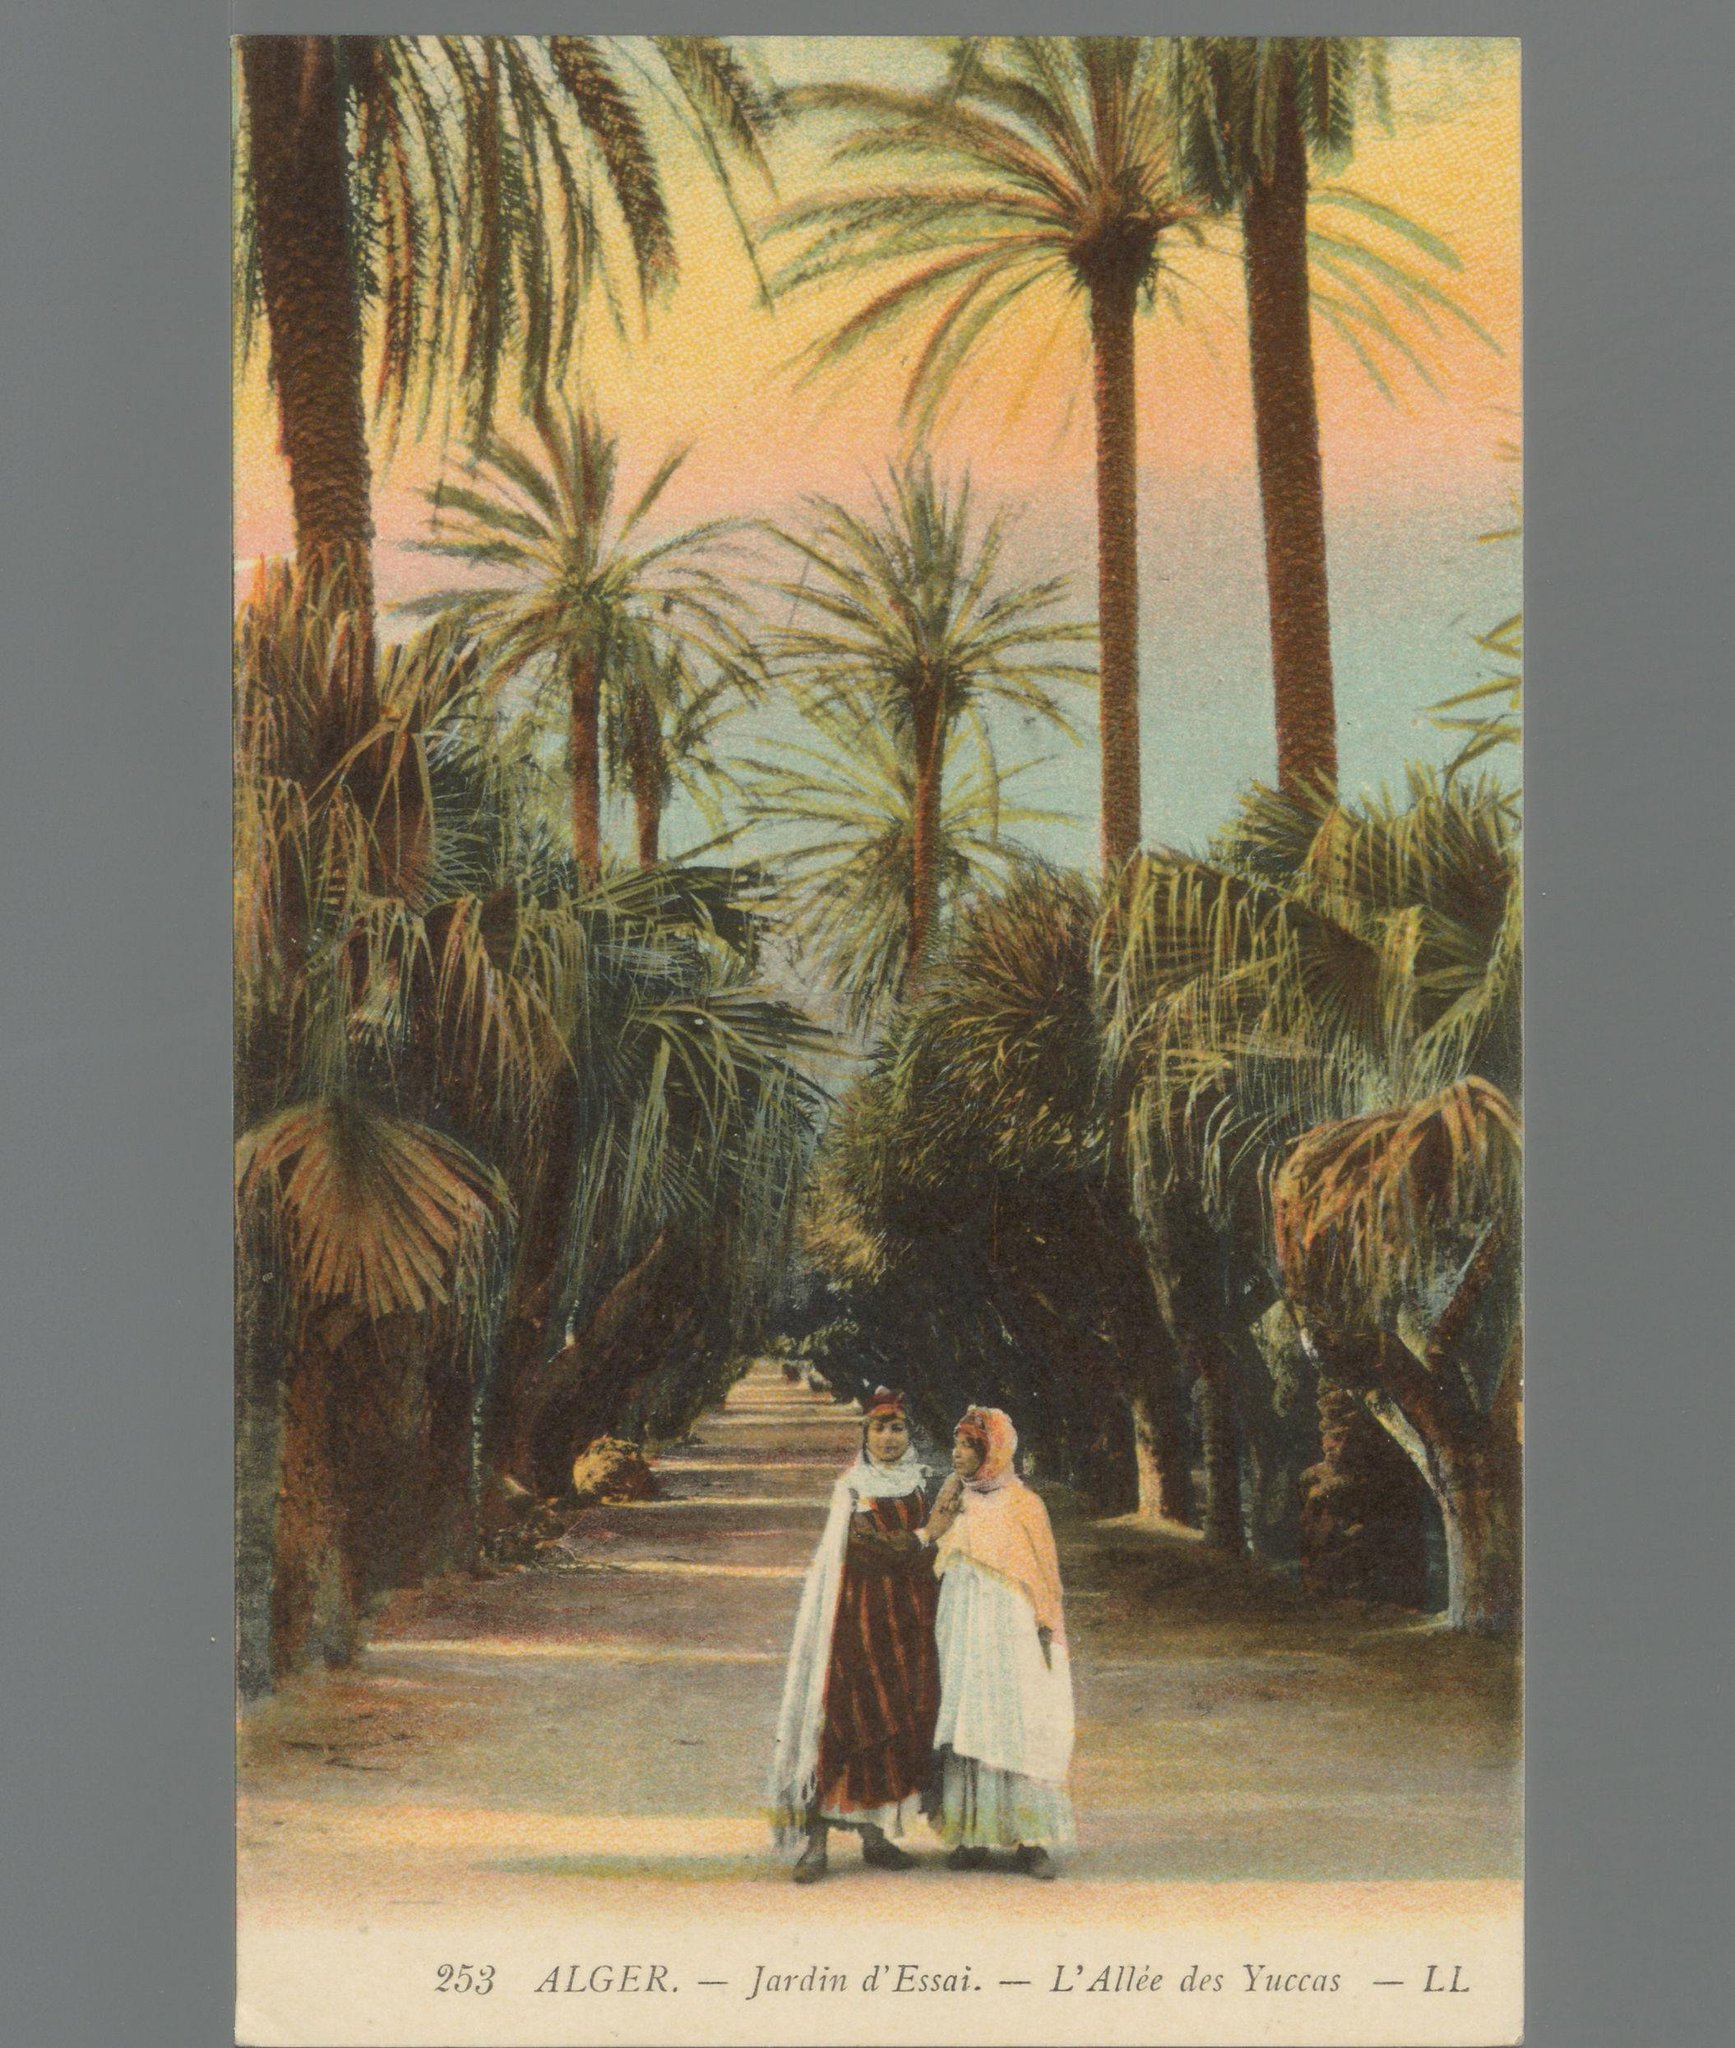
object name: photomechanical print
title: Alger. Jardin d'Essai. L'Allée des Yuccas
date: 1903-1920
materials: cardboard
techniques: photograph, lithograph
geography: paris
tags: public gardens, park (+ city(-scape) with figures, staffage), botanic garden, 'hortus botanicus', botanical garden hamma